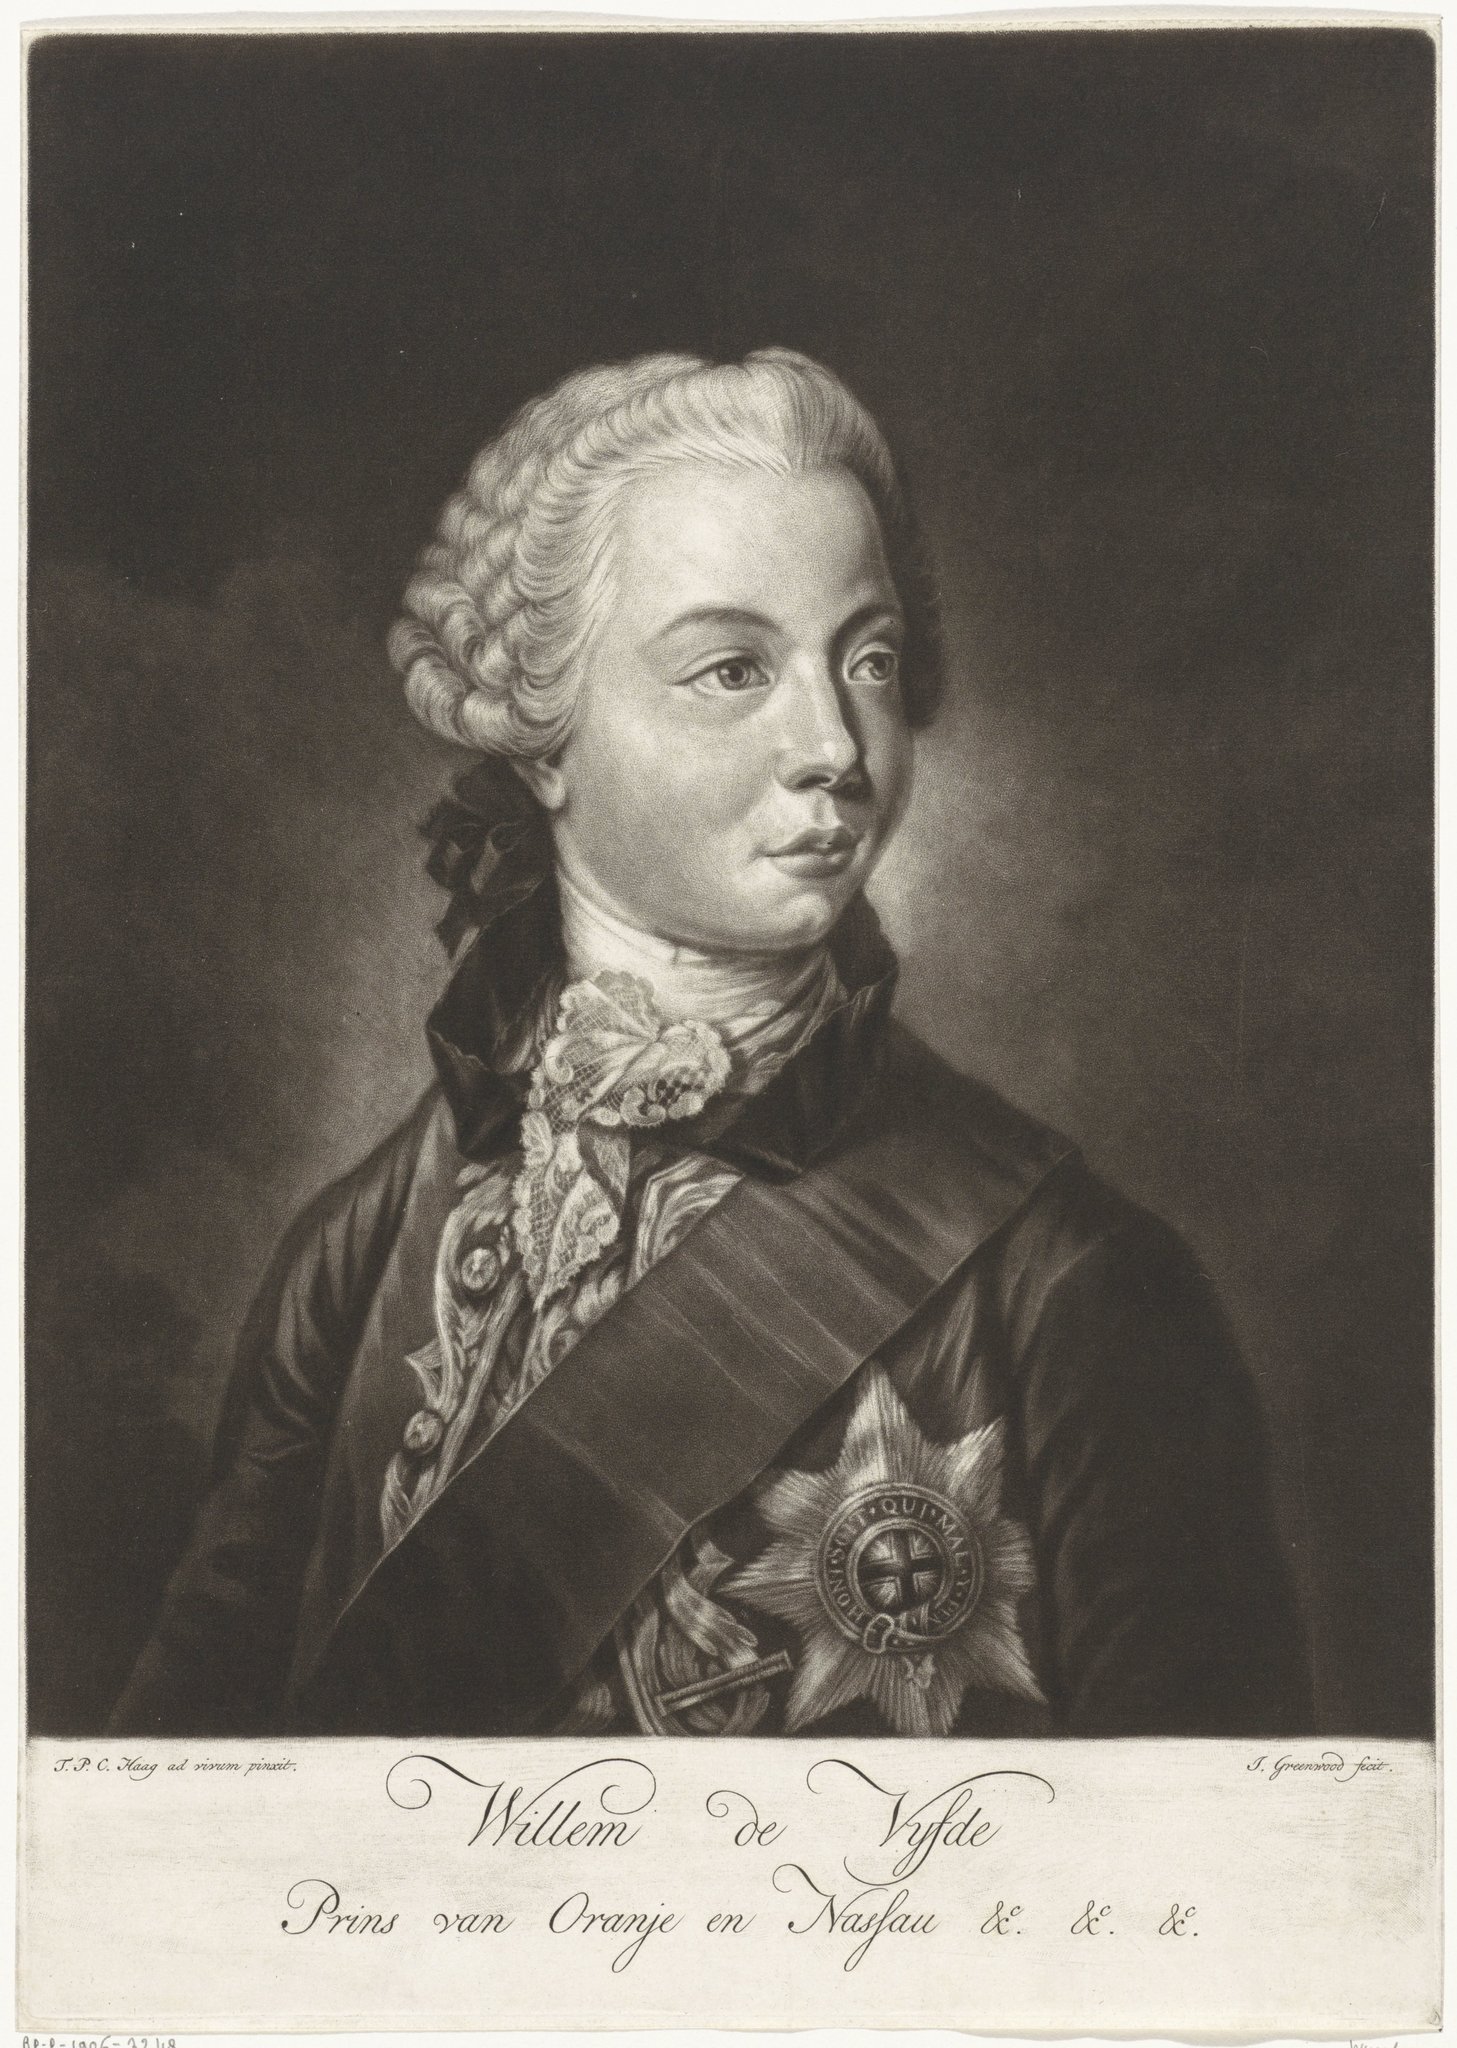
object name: print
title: Portret van Willem V, prins van Oranje-Nassau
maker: john greenwood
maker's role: auctioneer, draughtsman, print maker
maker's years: 1727-1792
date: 1755-1792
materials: paper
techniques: engraving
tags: the hague, william v (prince of orange)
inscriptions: collector's mark: Lugt 2228